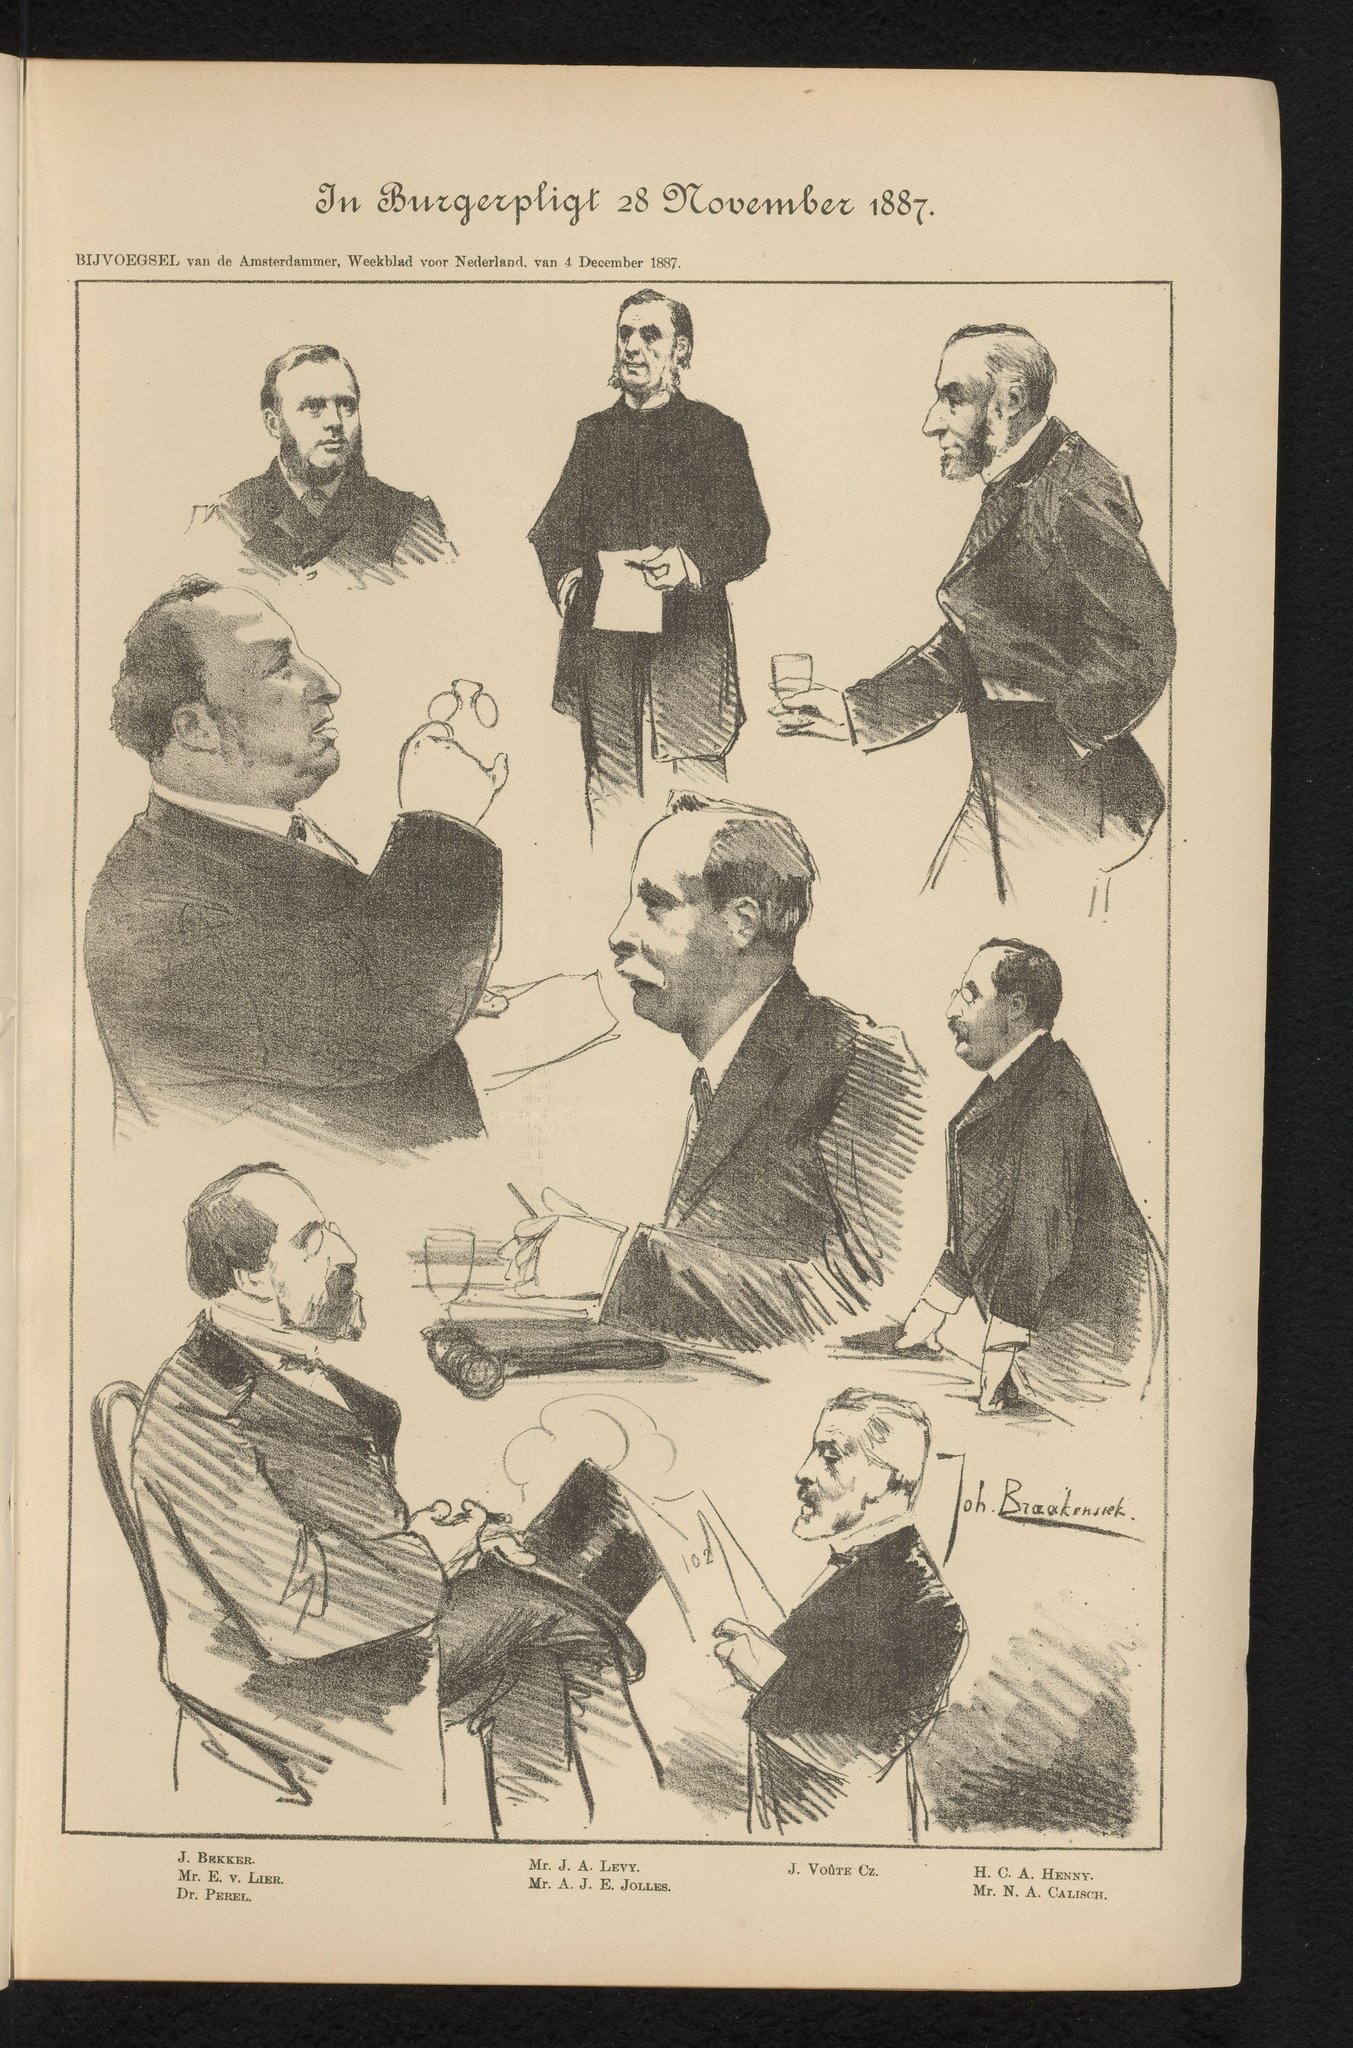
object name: print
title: In Burgerpligt 28 November 1887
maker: johan braakensiek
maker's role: draughtsman, print maker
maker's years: 1858-1940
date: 1887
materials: paper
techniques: lithograph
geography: netherlands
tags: voting, election, historical persons, political meeting, propaganda meeting, amsterdam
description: Blad met portretten van sprekers op een bijeenkomst van de Amsterdamse liberale kiesvereniging Burgerplicht op 28 november 1887.